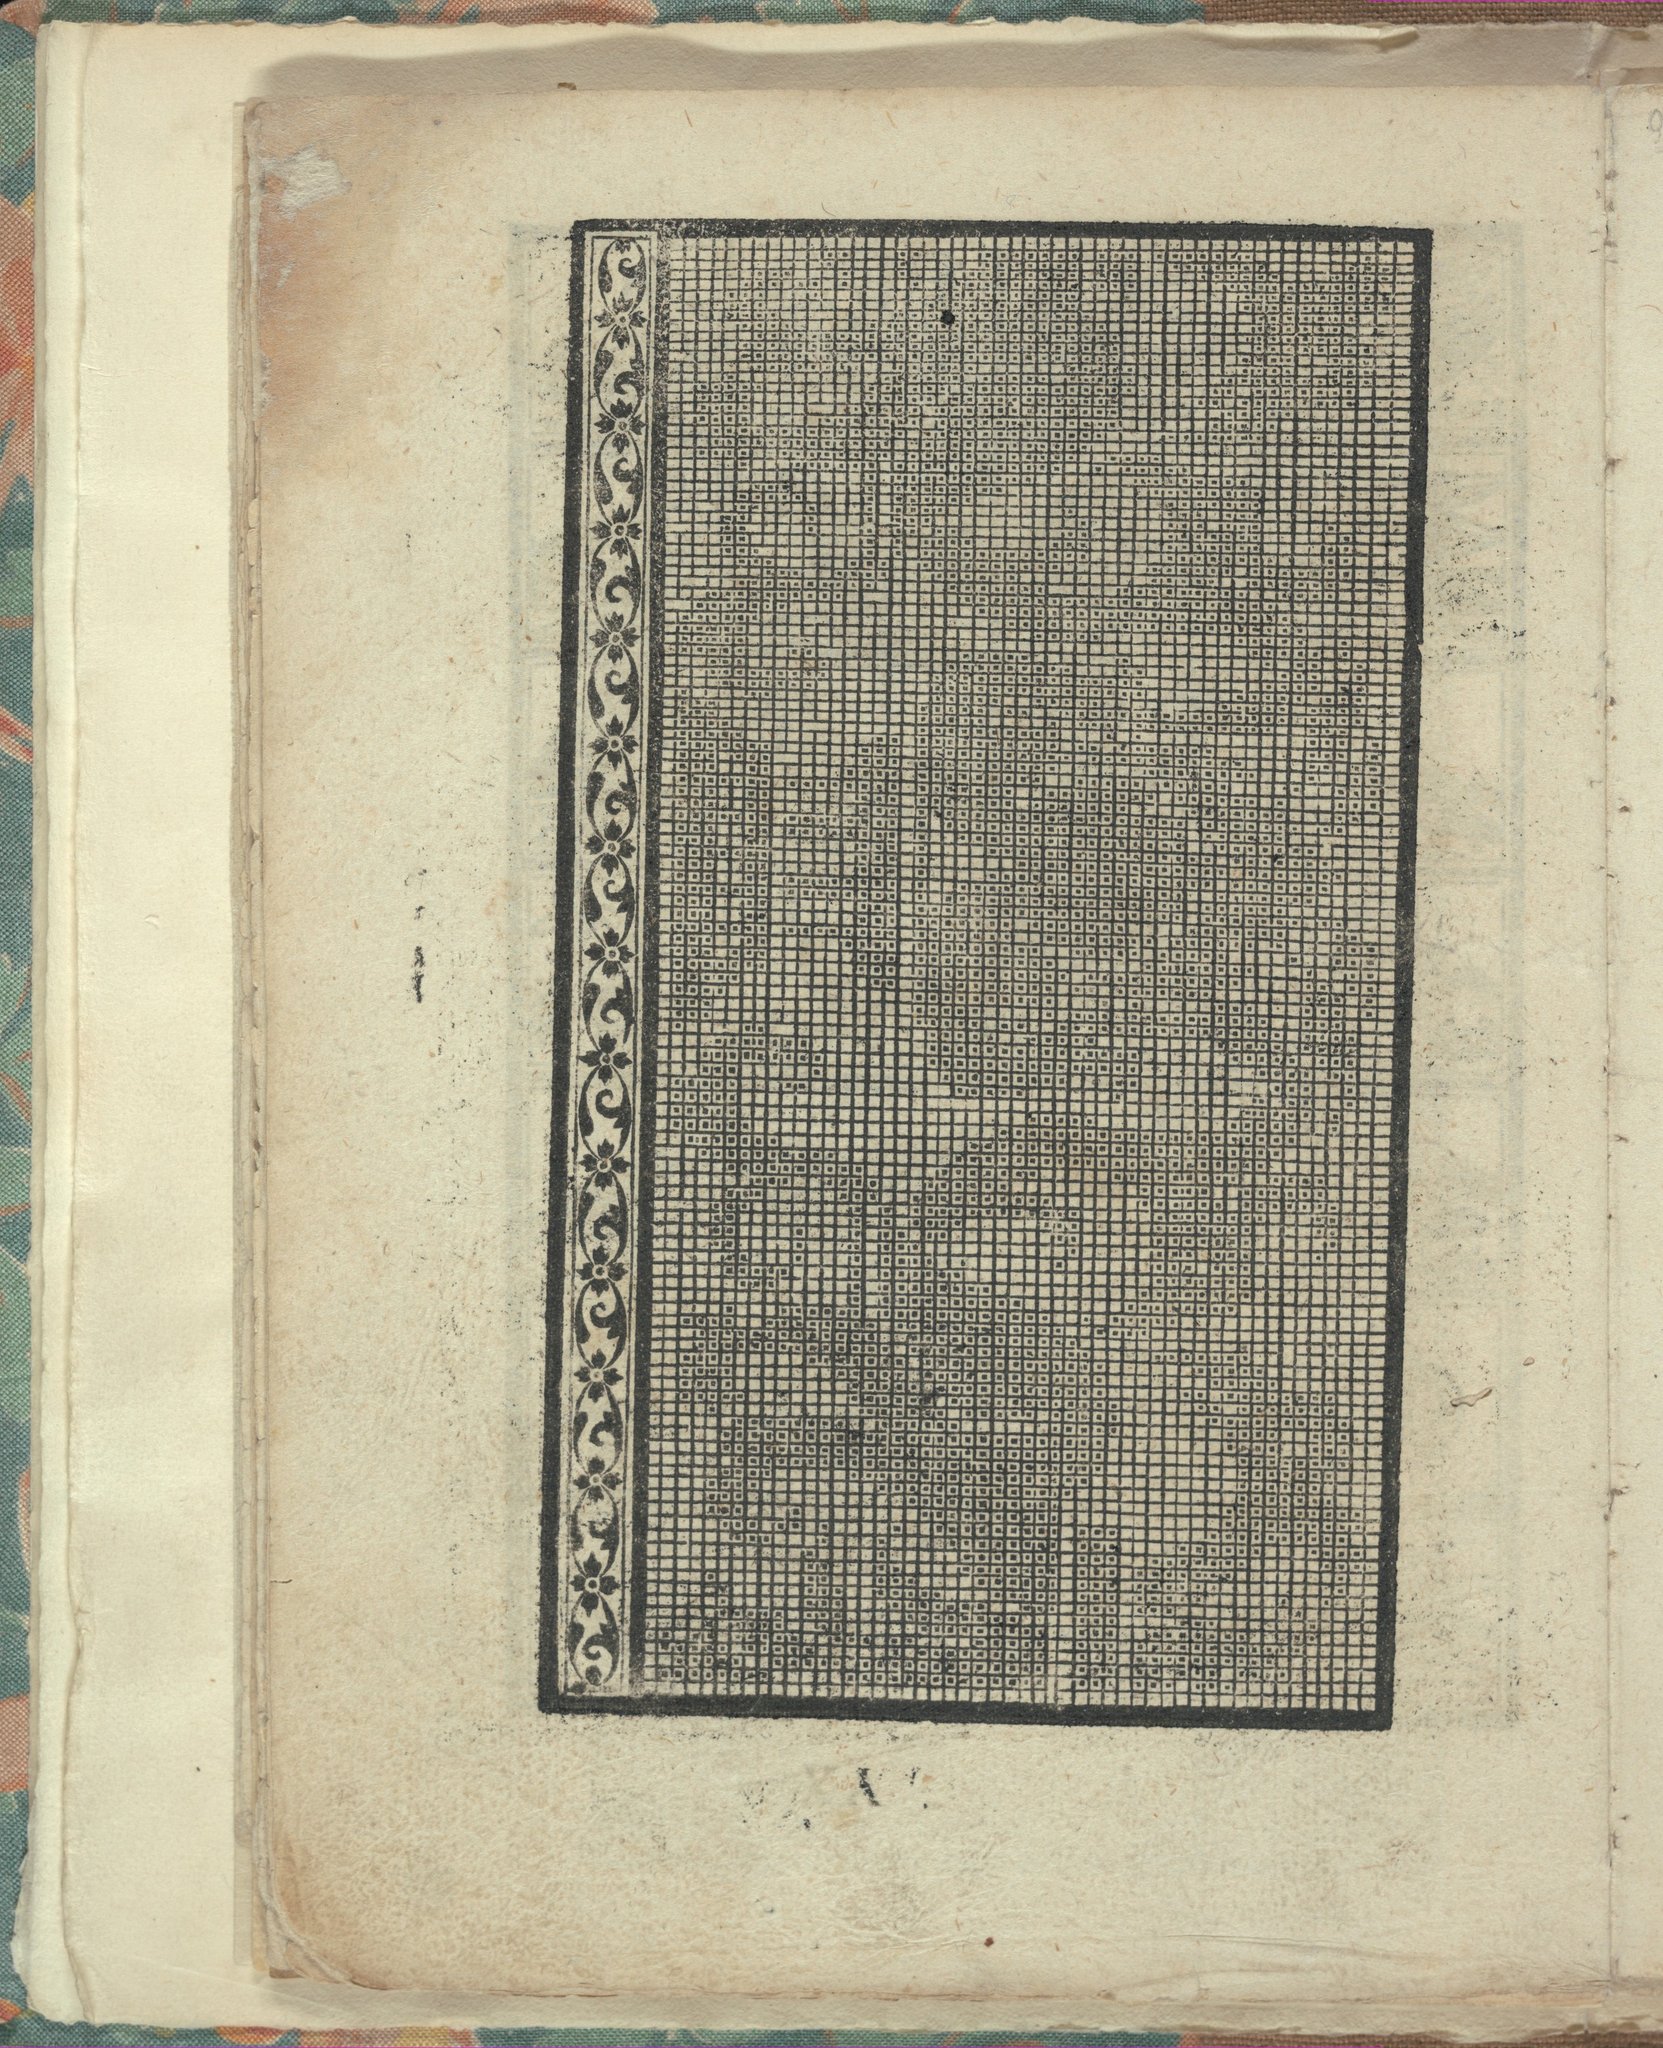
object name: book print ornament architecture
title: Opera Nova Universali intitulata Corona di racammi, page 21 (verso)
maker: giovanni andrea vavassore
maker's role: publisher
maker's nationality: italian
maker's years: 1530-1573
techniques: woodcut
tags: birds,flowers